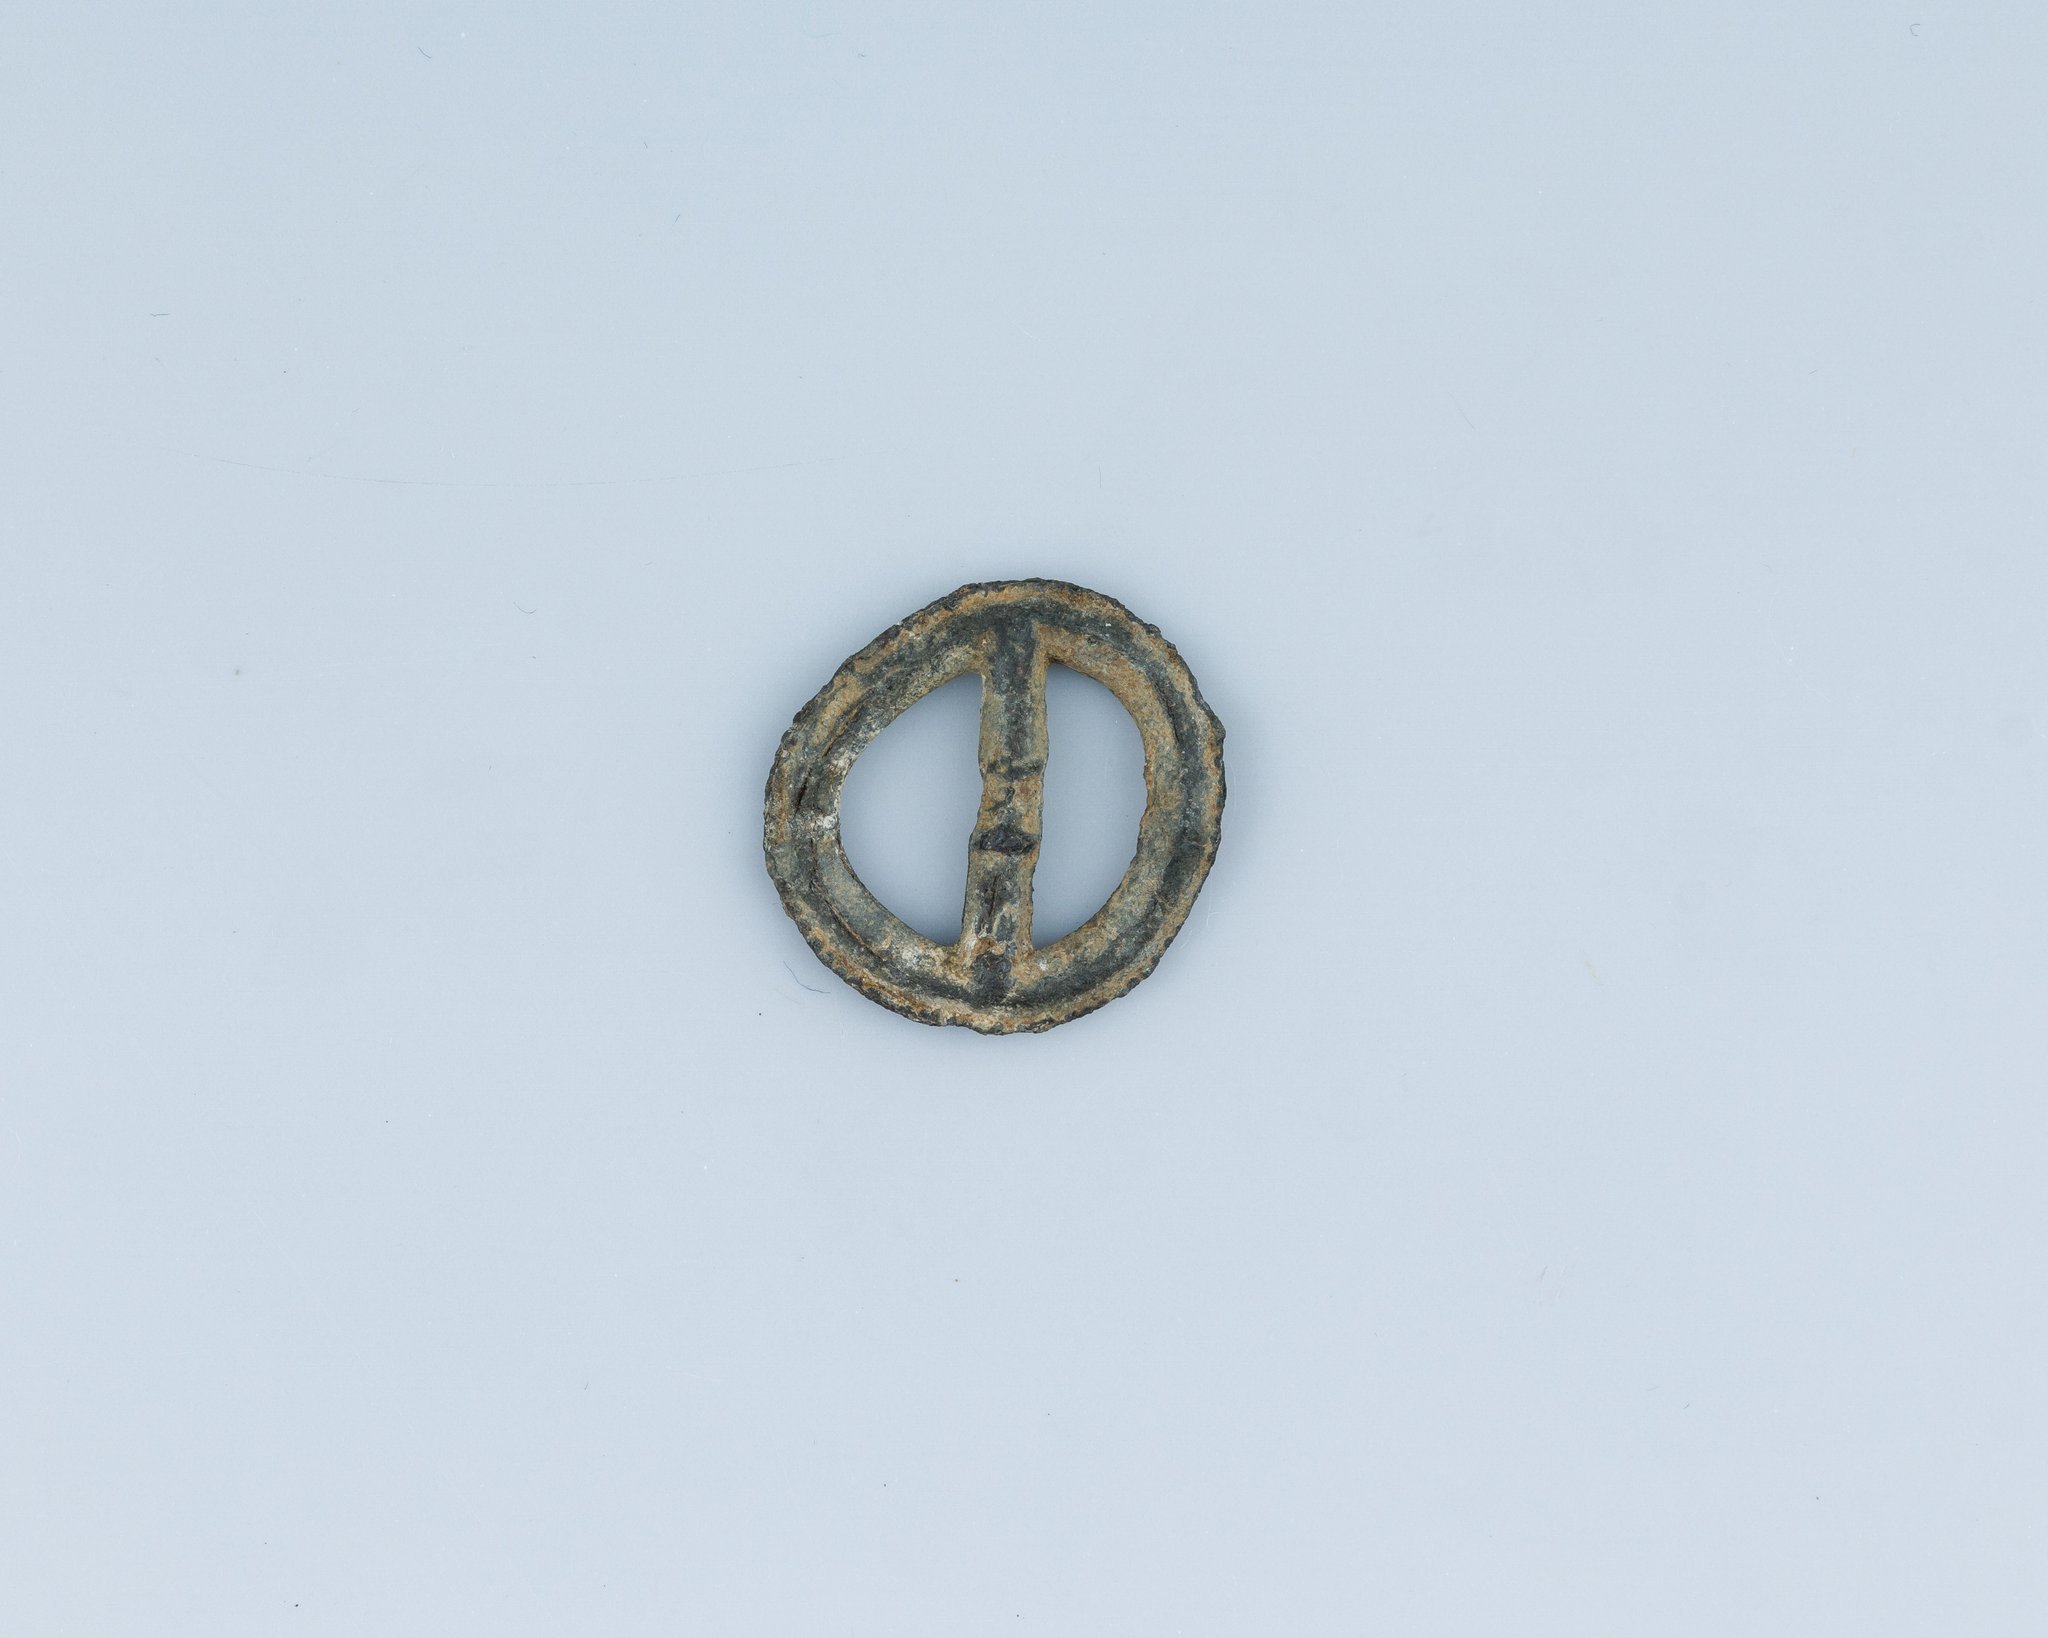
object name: buckle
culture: european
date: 1401-1600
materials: bronze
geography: germany